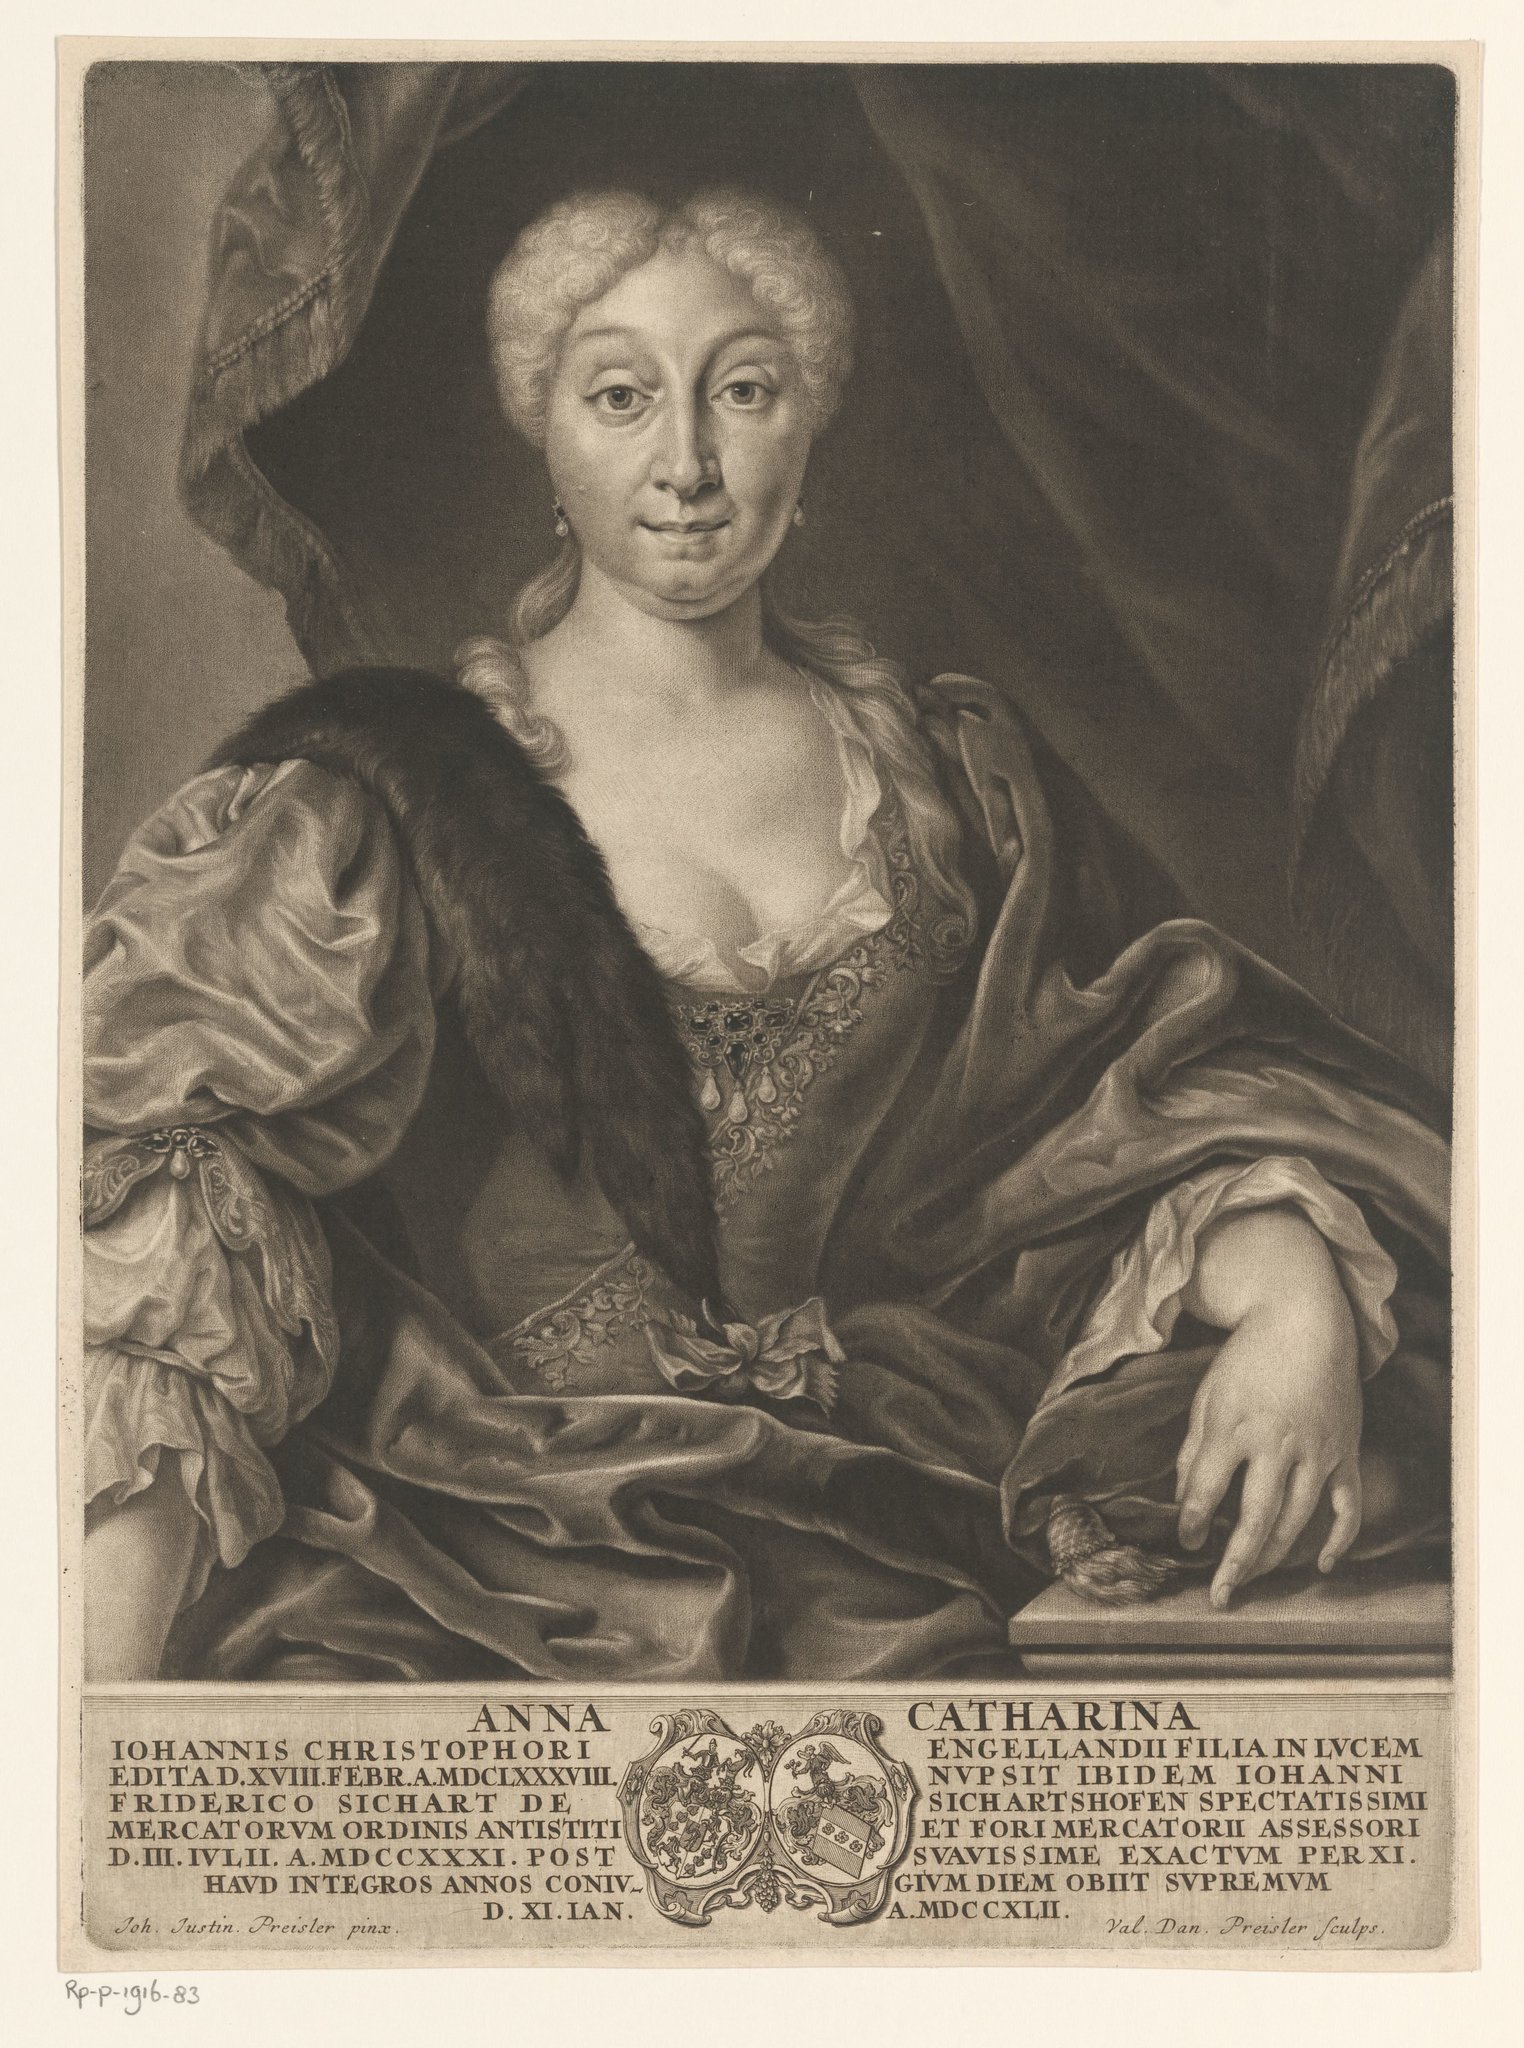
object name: print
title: Portret van Johann Jakob Breitinger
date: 1749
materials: paper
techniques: etching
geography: nuremberg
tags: writing tools, historical persons, book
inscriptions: collector's mark: Lugt 2228